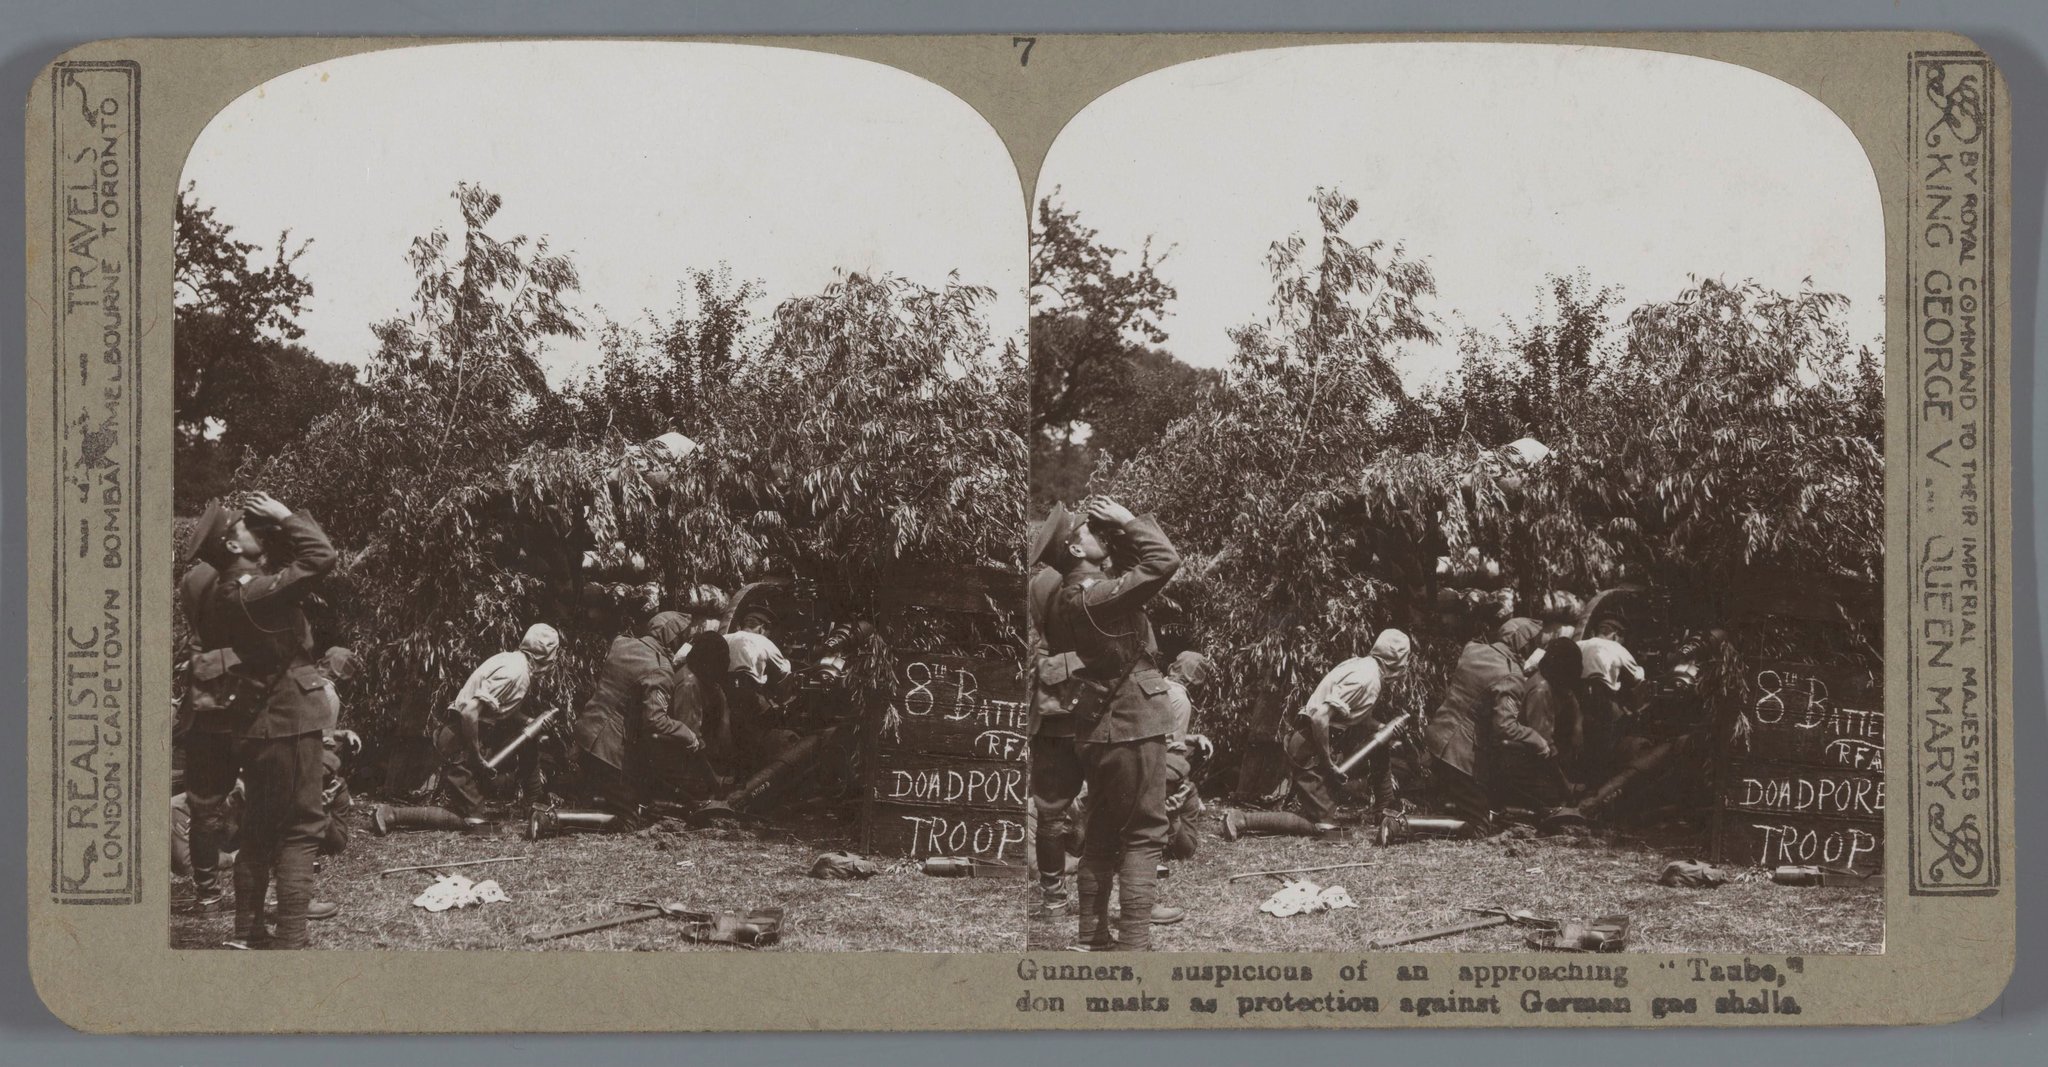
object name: stereograph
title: Gunners, suspicious of an approaching "Taube", don masks as protection against German gas shells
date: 1914-1918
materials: cardboard, photographic support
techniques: gelatin silver print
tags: private soldier, violent death by gassing; asphyxiation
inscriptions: number: ‘7’, inscription: ‘By Royal command to their Imperial majesties King George V and Queen Mary’